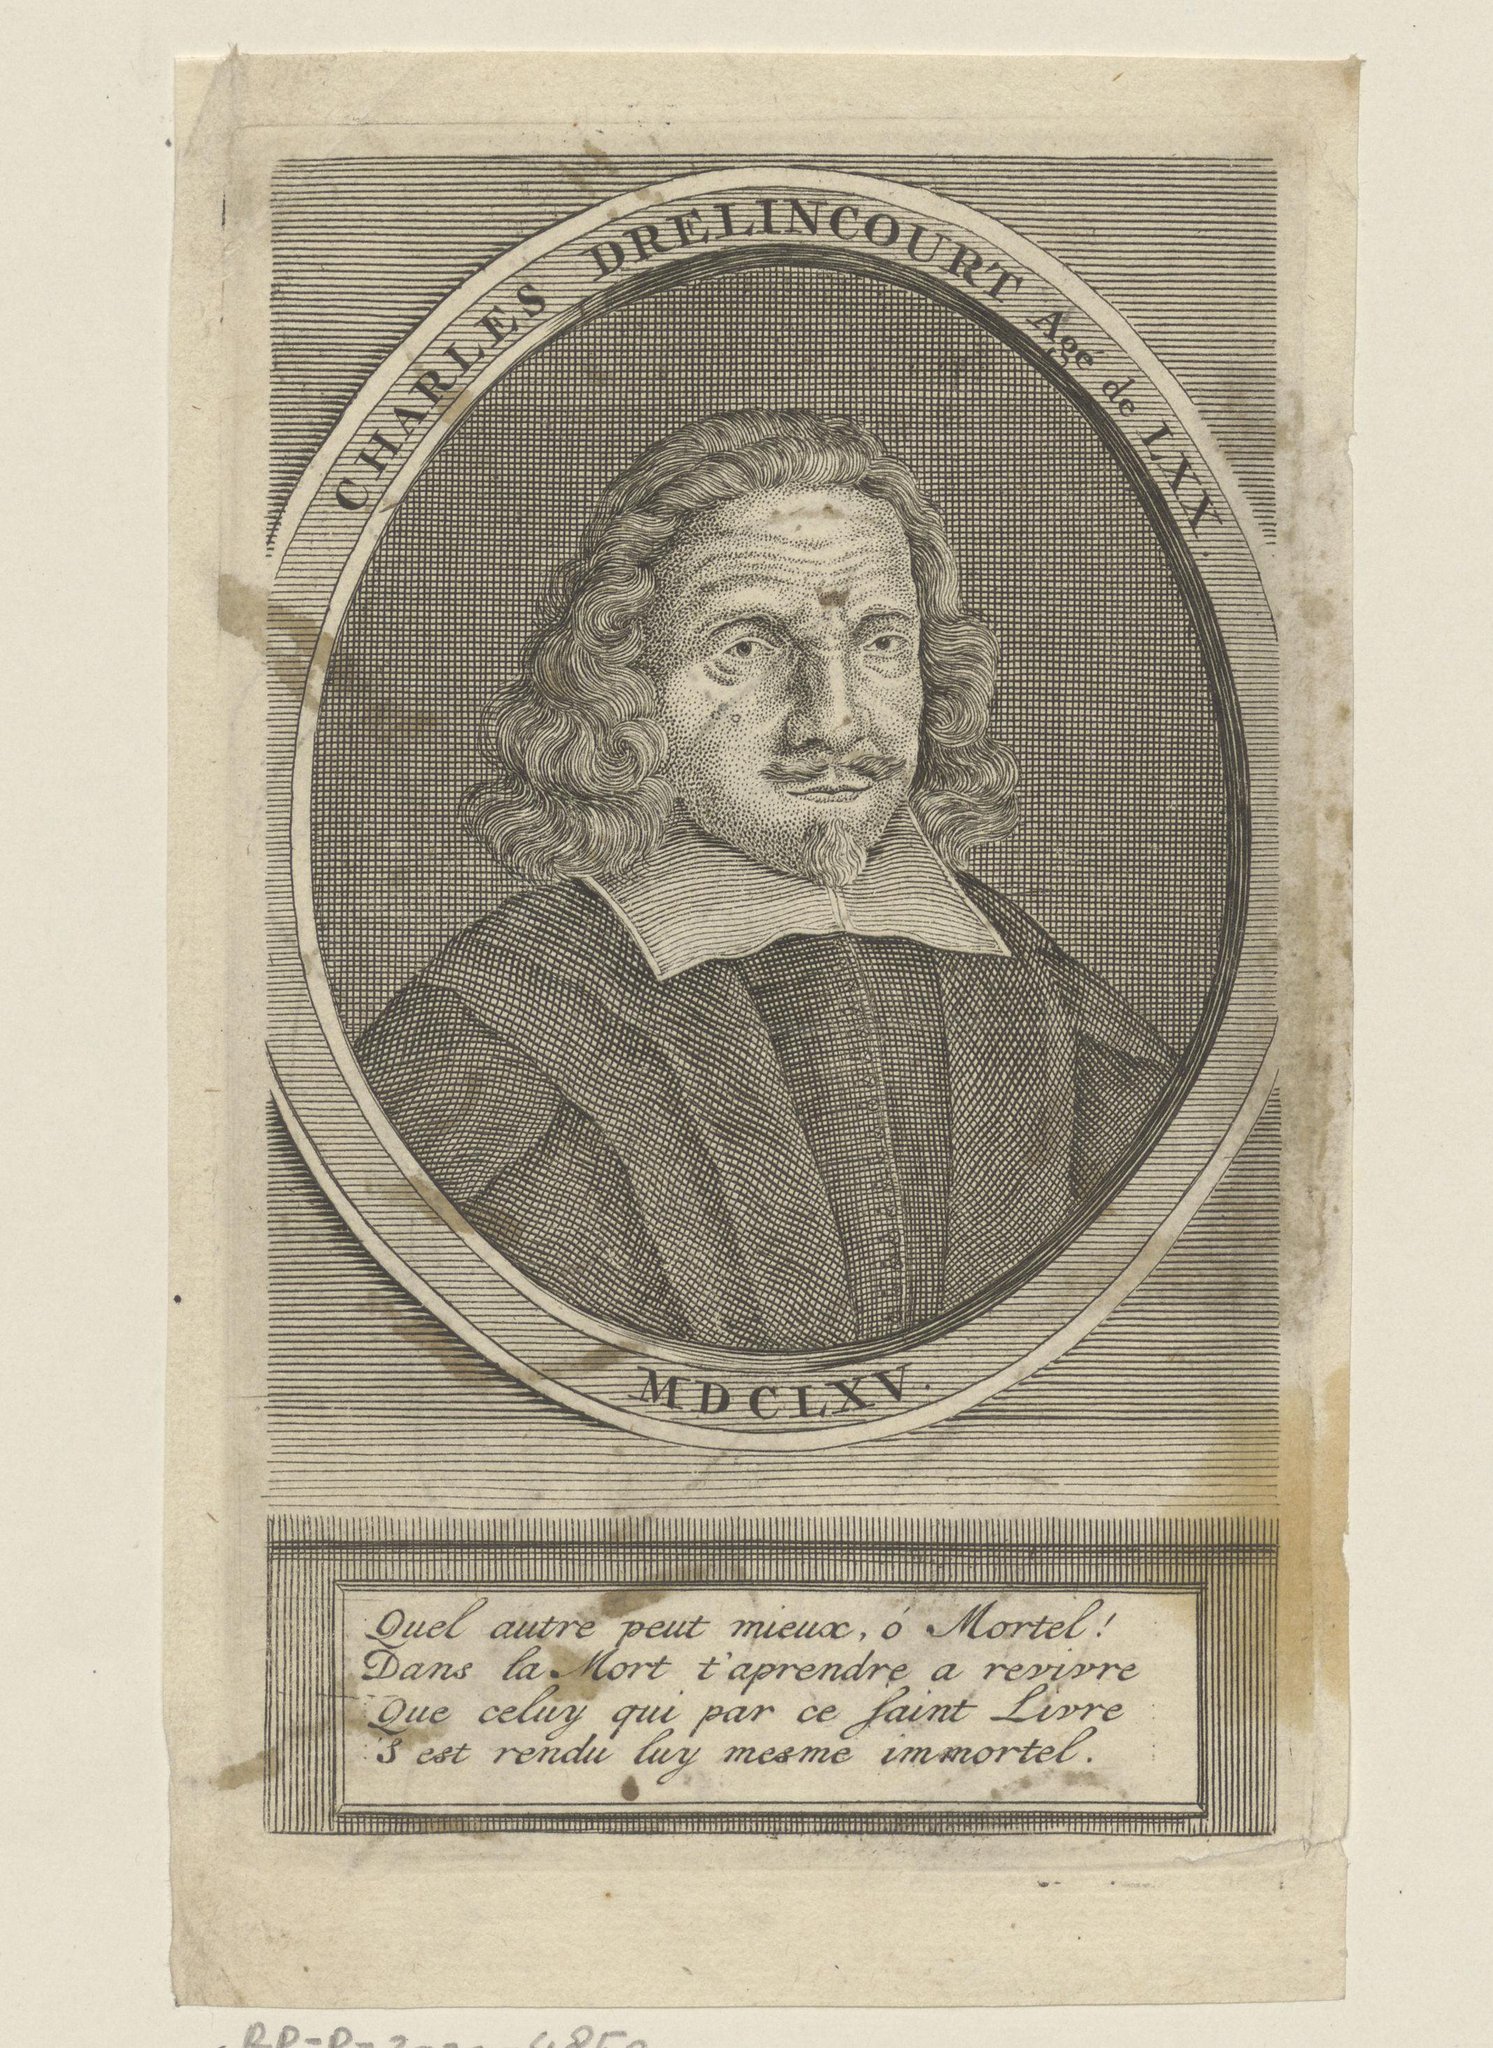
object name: print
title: Portret van Charles Drelincourt op 70-jarige leeftijd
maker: Anonymous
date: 1665-1770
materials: paper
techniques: engraving, etching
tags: theologian, historical persons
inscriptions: inscription: ‘[...] D/ je[...]’